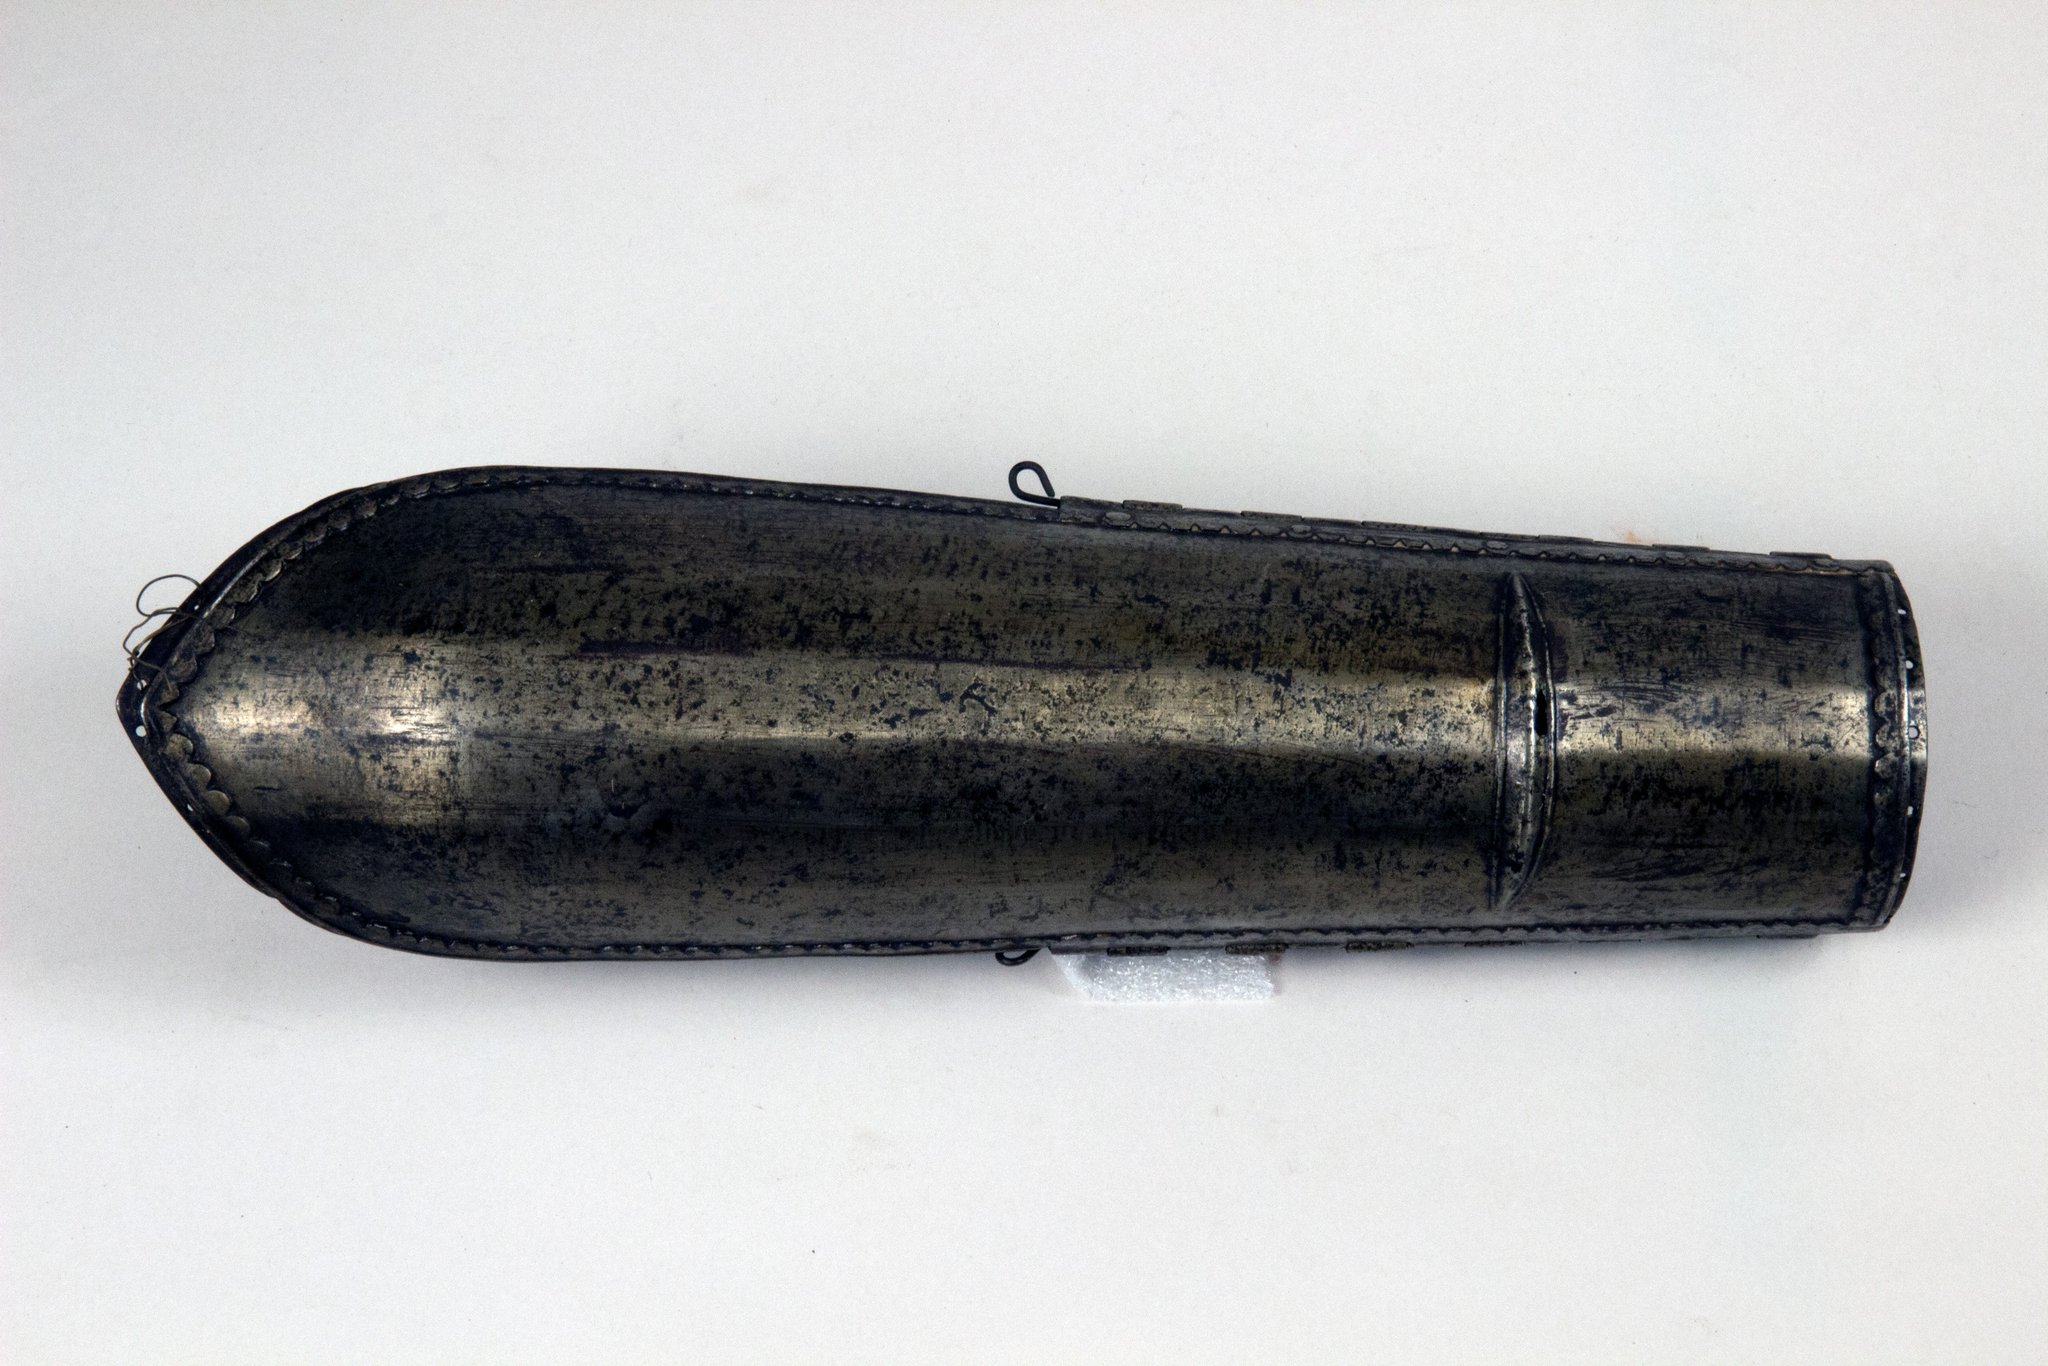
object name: arm guard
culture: indian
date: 1601-1800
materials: steel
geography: india